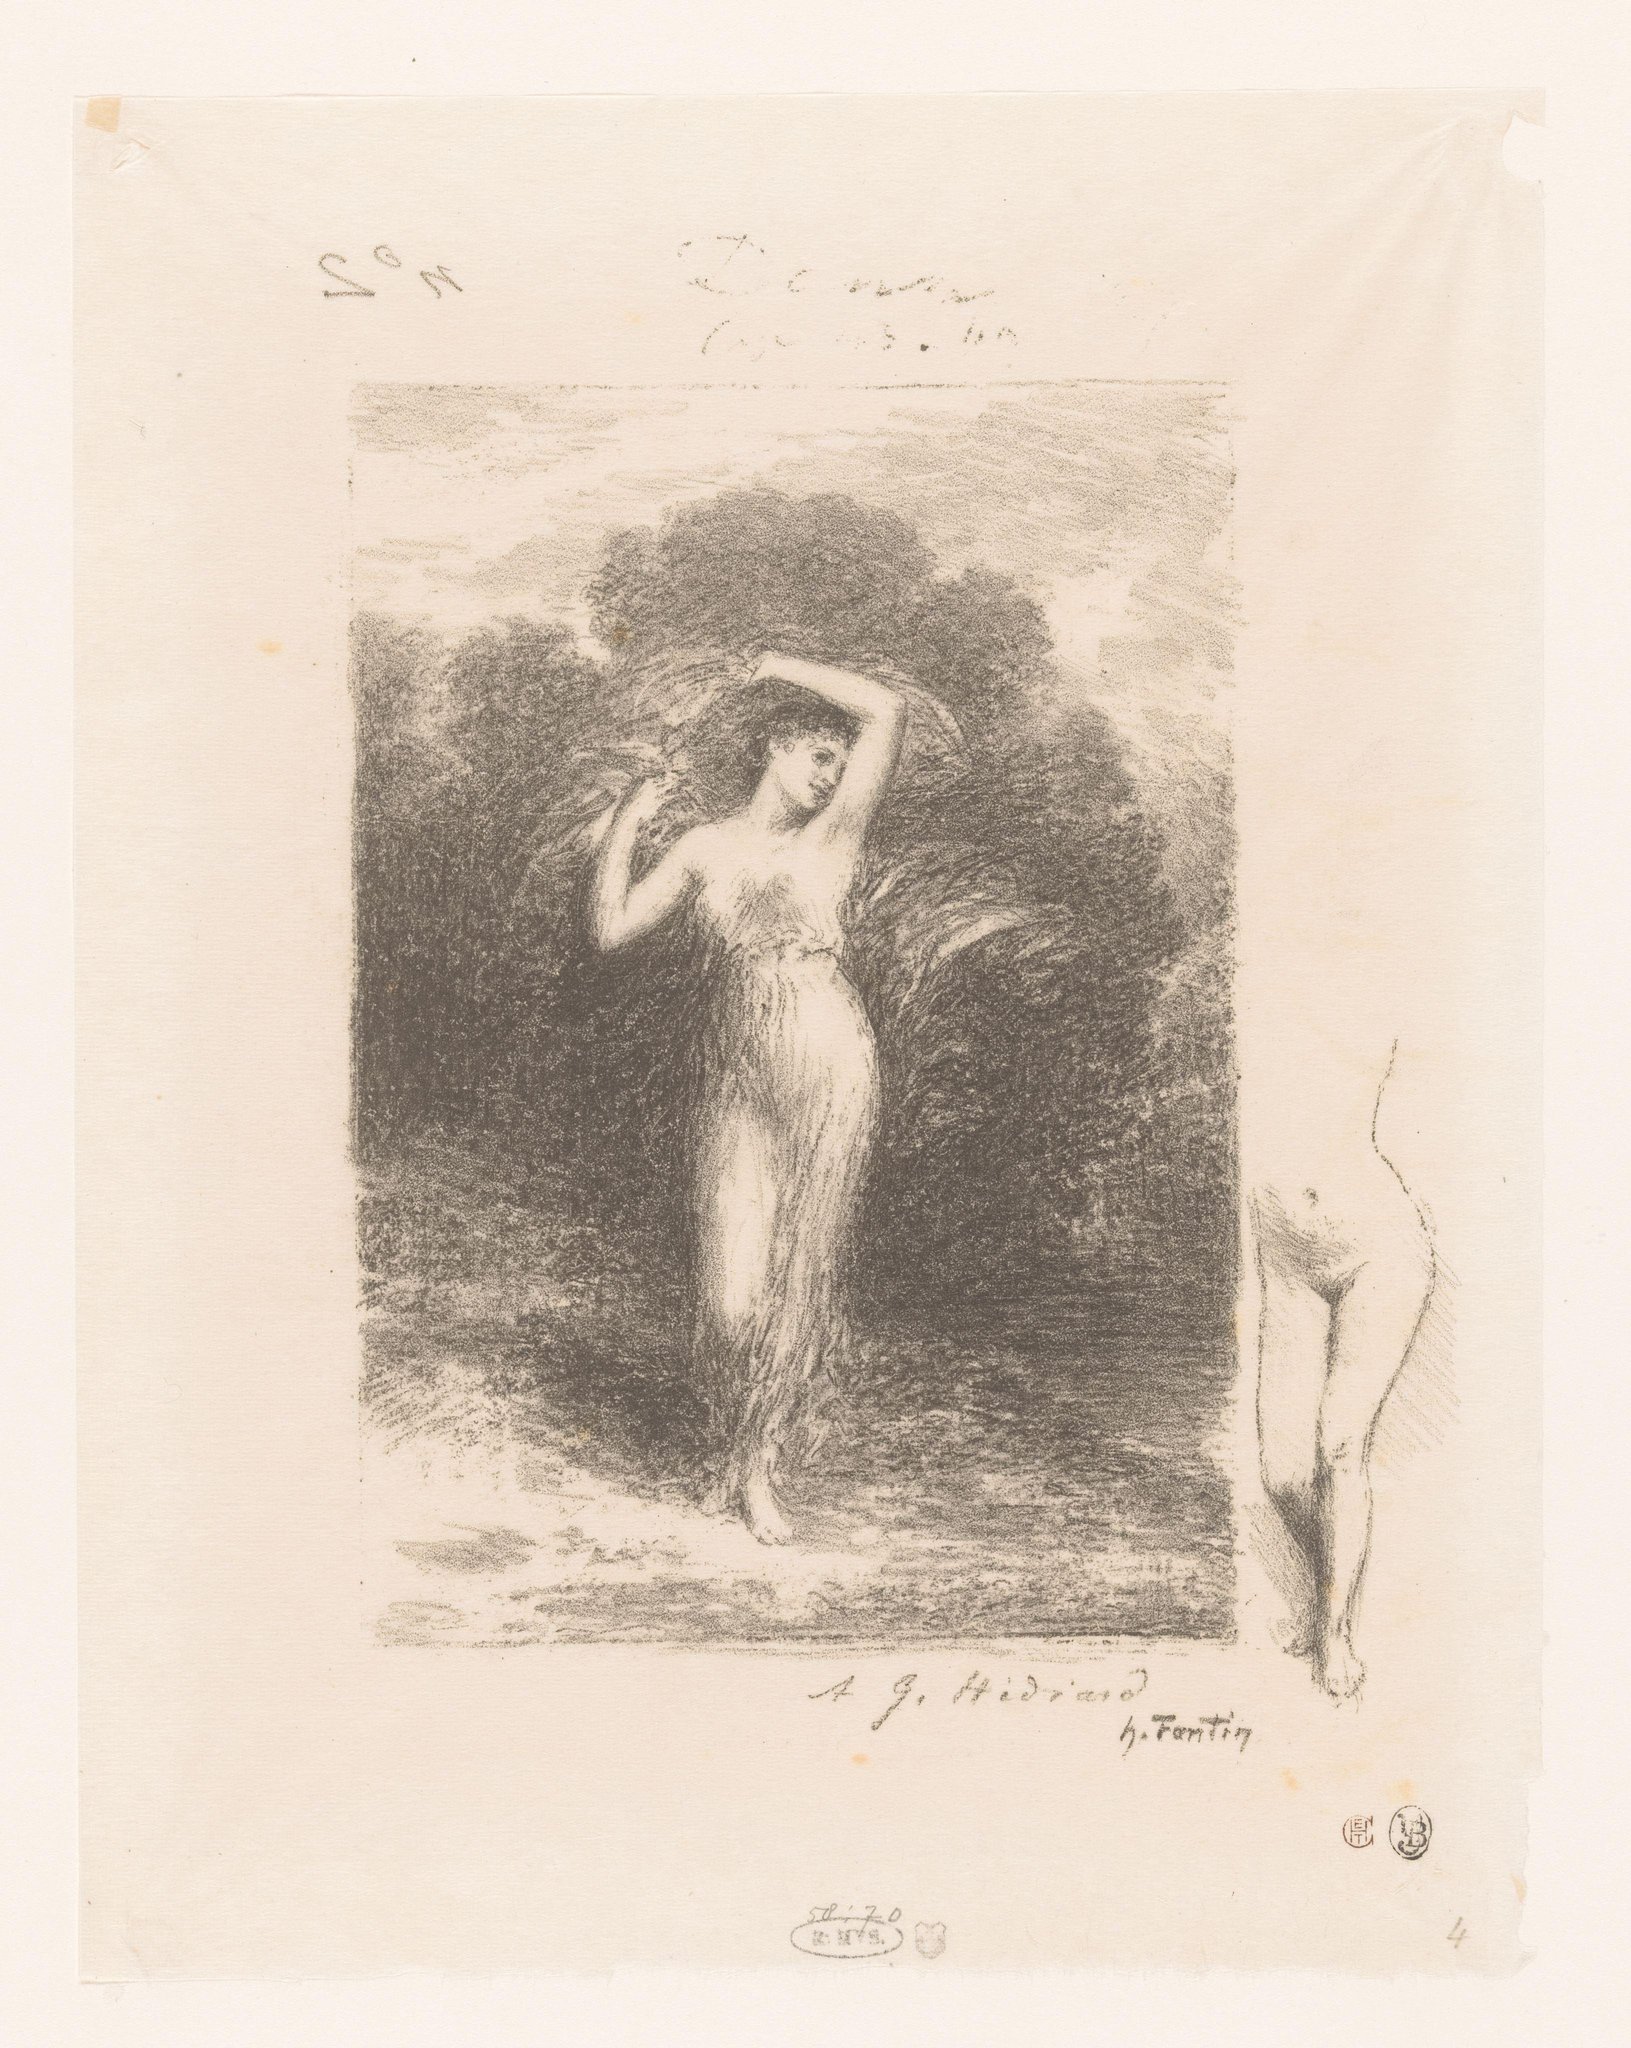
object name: print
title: Jonge vrouw met sjaal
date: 1905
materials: paper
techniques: lithography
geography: paris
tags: adolescent, young woman, maiden, veil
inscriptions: collector's mark: Lugt 533b, collector's mark: Lugt 2760, collector's mark: Lugt 2228a, collector's mark: Lugt 421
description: Illustratie bij het gedicht Le Malade van André Chénier, specifiek de verzen: Que je la voie encore, cette vierge charmante!